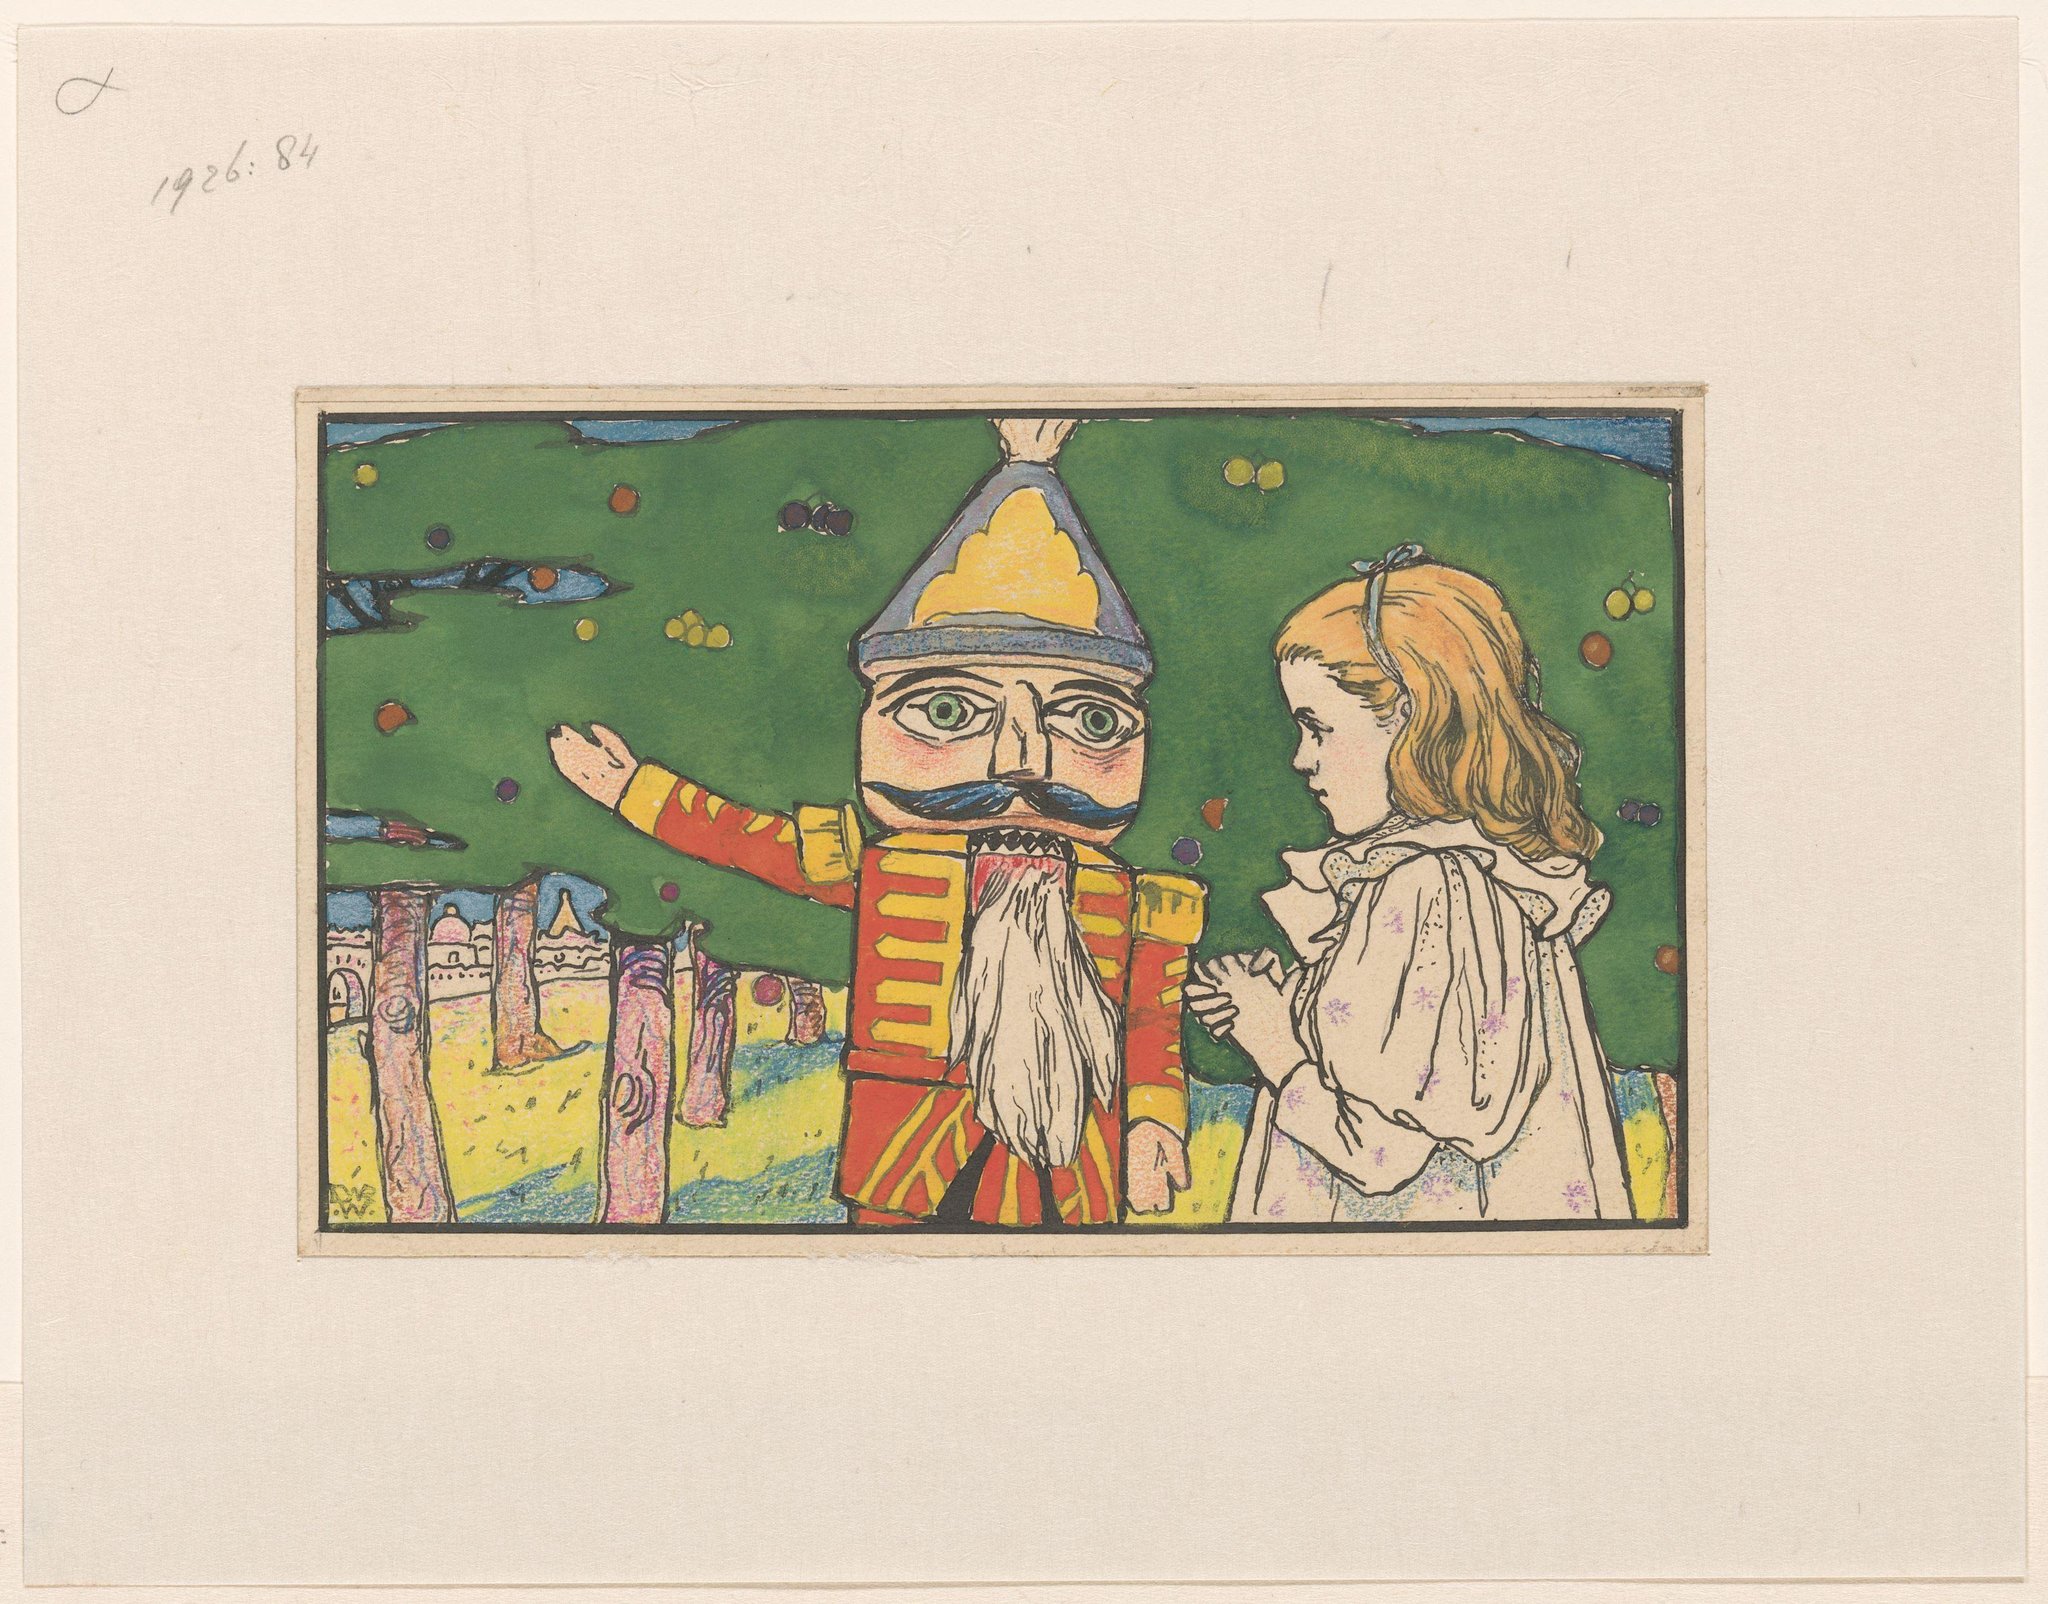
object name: drawing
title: Bandontwerp voor: E.T.A. Hoffmann, Notenkraker en muizenkoning, 1898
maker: willem wenckebach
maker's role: designer, draughtsman, painter, print maker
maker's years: 1860-1937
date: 1898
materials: chalk, ink, paint, paper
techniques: brush, pen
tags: city-view in general; 'veduta', (playing with) dolls, forest path or lane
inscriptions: number: ‘no 169’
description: Marie en de Notenkraker staan op een pad in een bosachtige omgeving. De Notenkraker houdt zijn rechterarm opgeheven en wijst naar een een stad die in de verte te zien is.